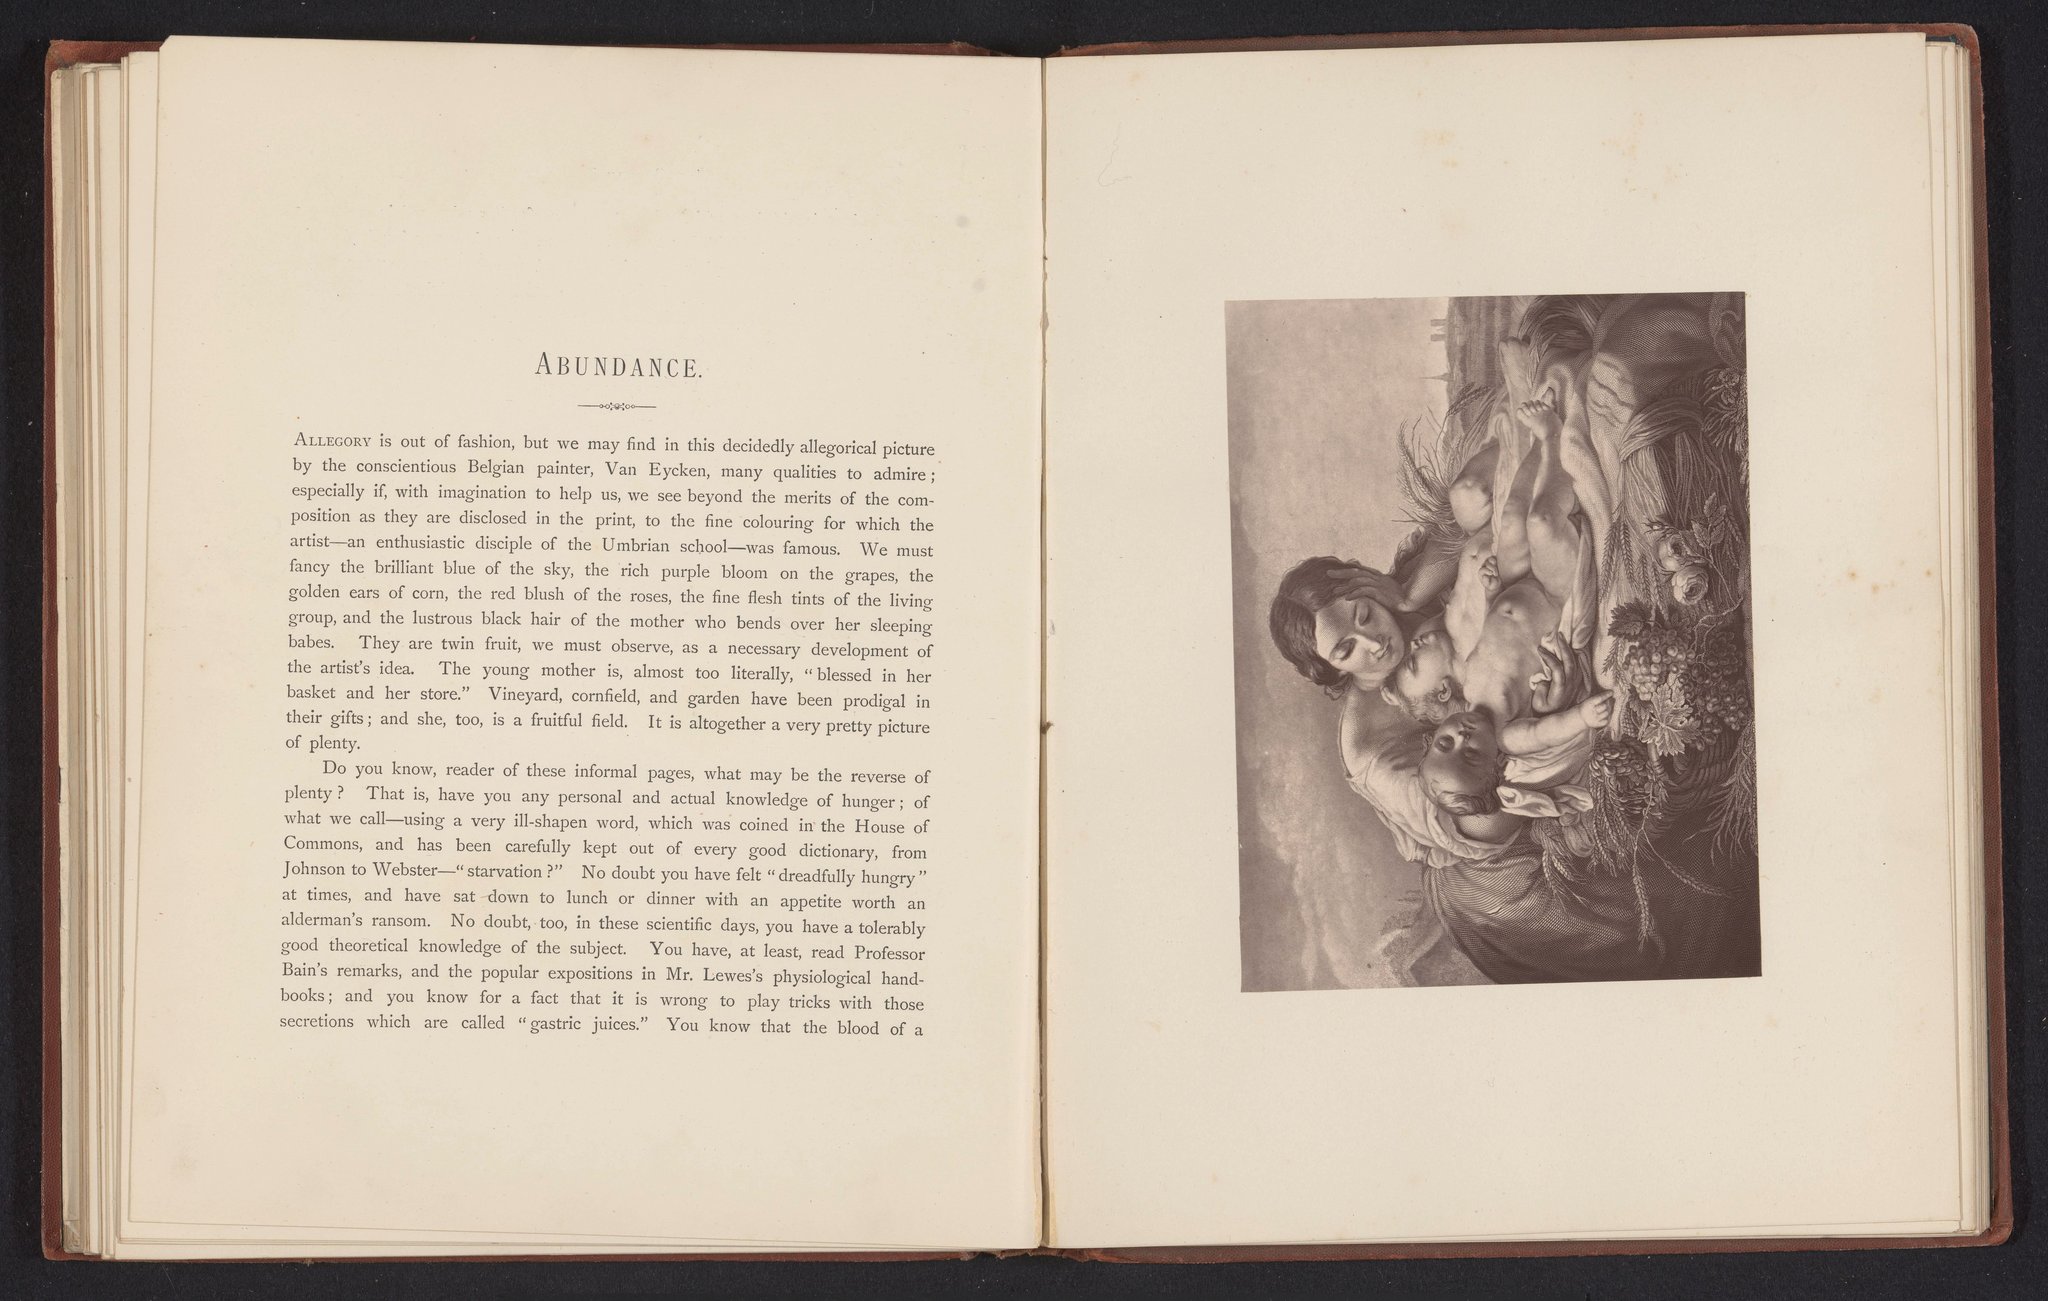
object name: page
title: Fotoreproductie van een prent naar een schilderij, voorstellende een moeder met twee slapende kinderen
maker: Anonymous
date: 1861-1871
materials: paper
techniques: woodburytype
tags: watching a sleeping child